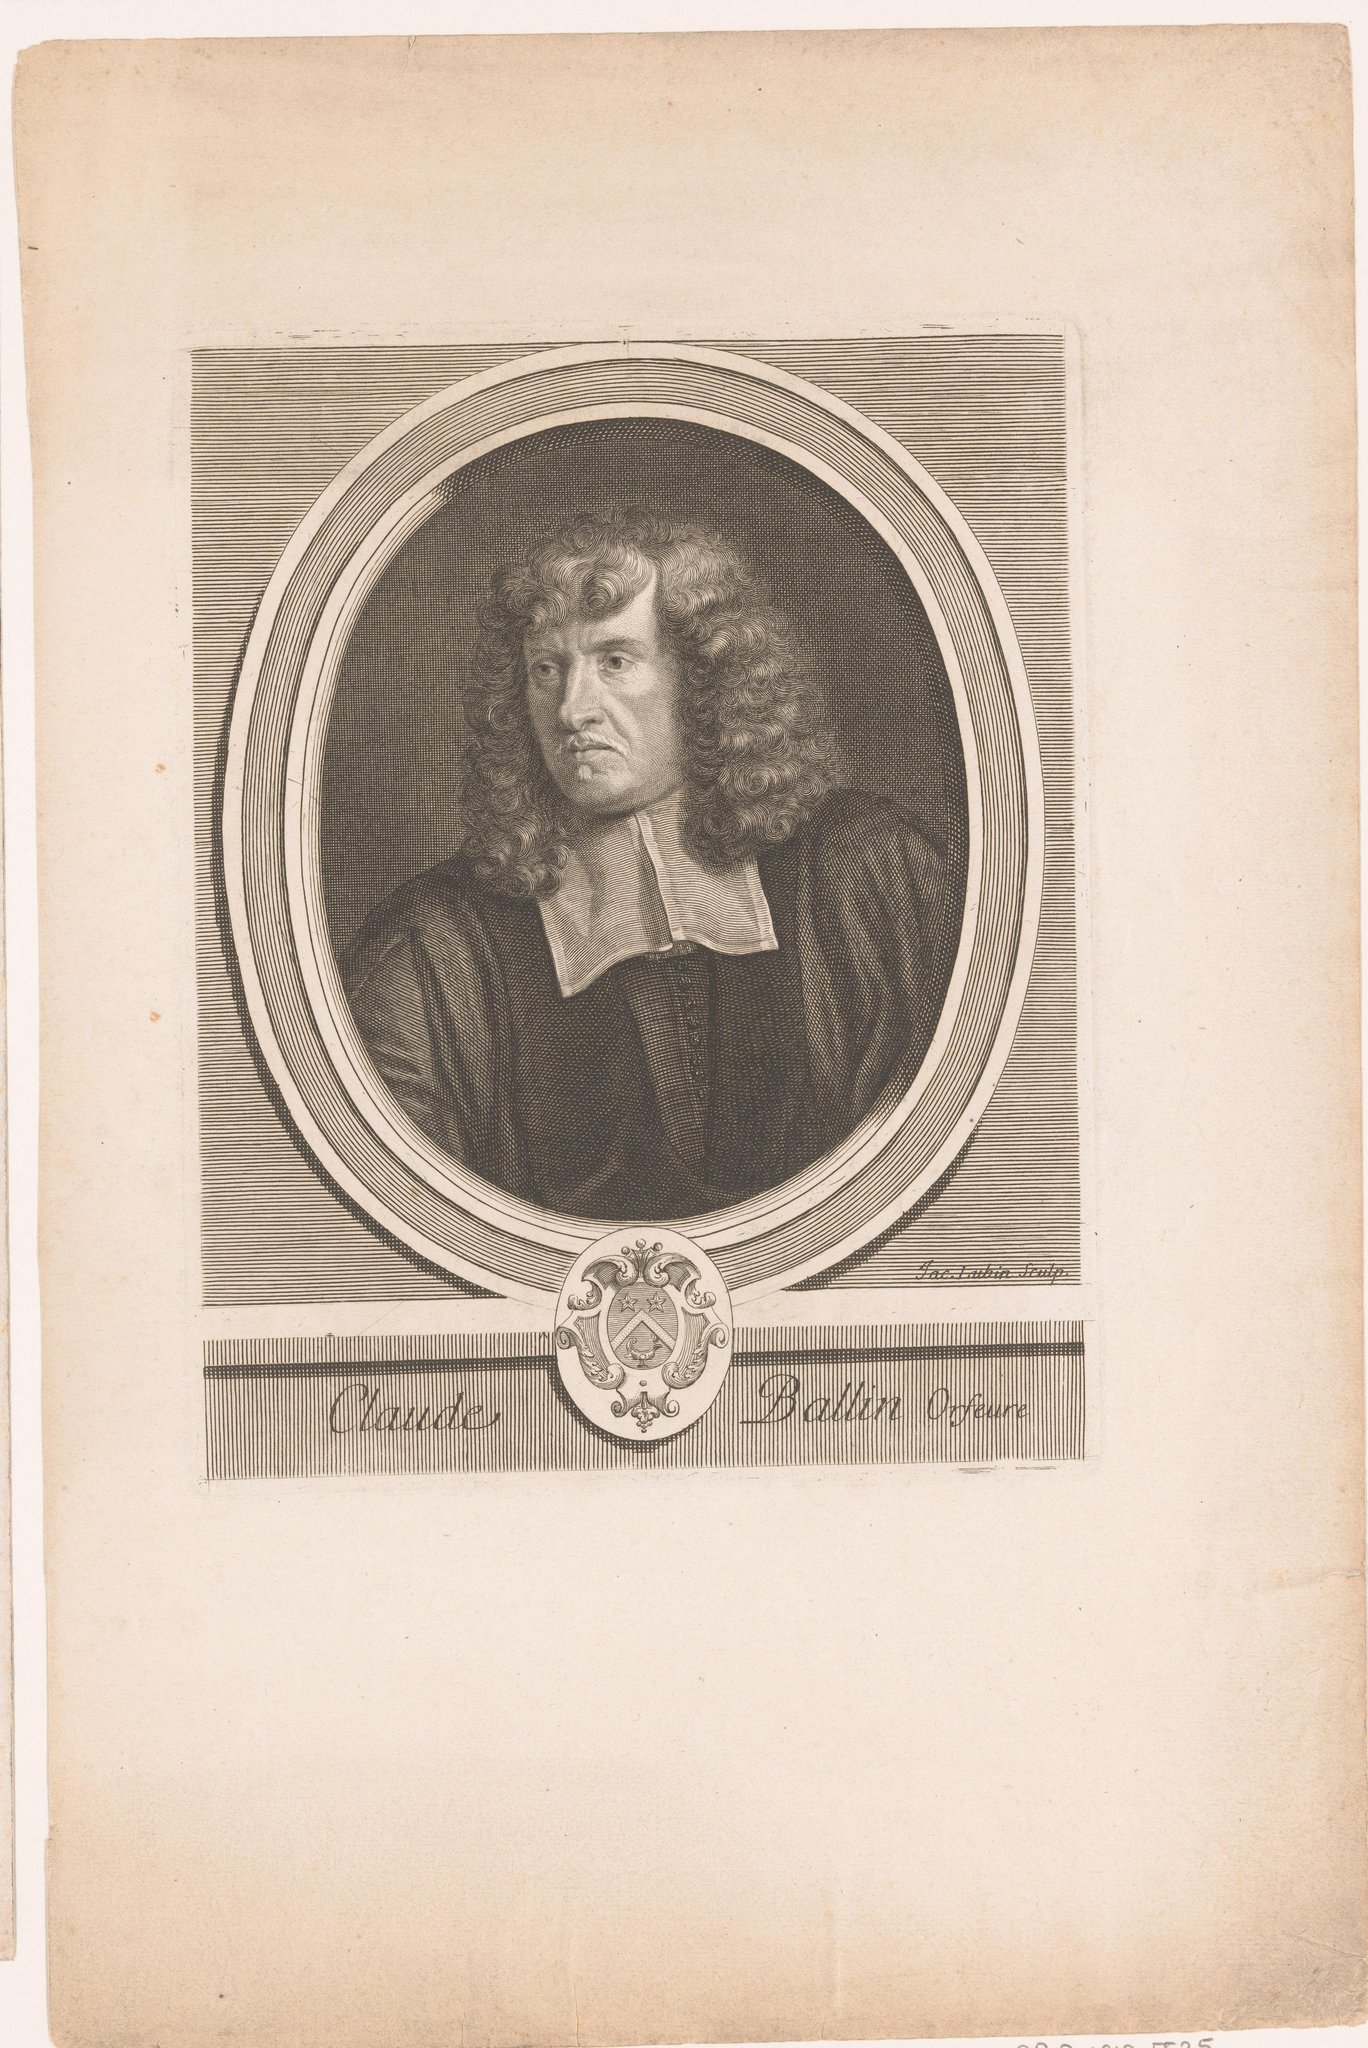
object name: book illustration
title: Portret van Claude Ballin I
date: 1696-1700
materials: paper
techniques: engraving, etching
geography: paris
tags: paris, print maker, claude ballin (i), historical persons, jeweller, goldsmith, silversmith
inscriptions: collector's mark: Lugt 2228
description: Prent uit: Perrault, Charles. Les hommes illustres qui ont paru en France pendant ce siècle. Parijs: Antoine Dezallier, 1696-1700.